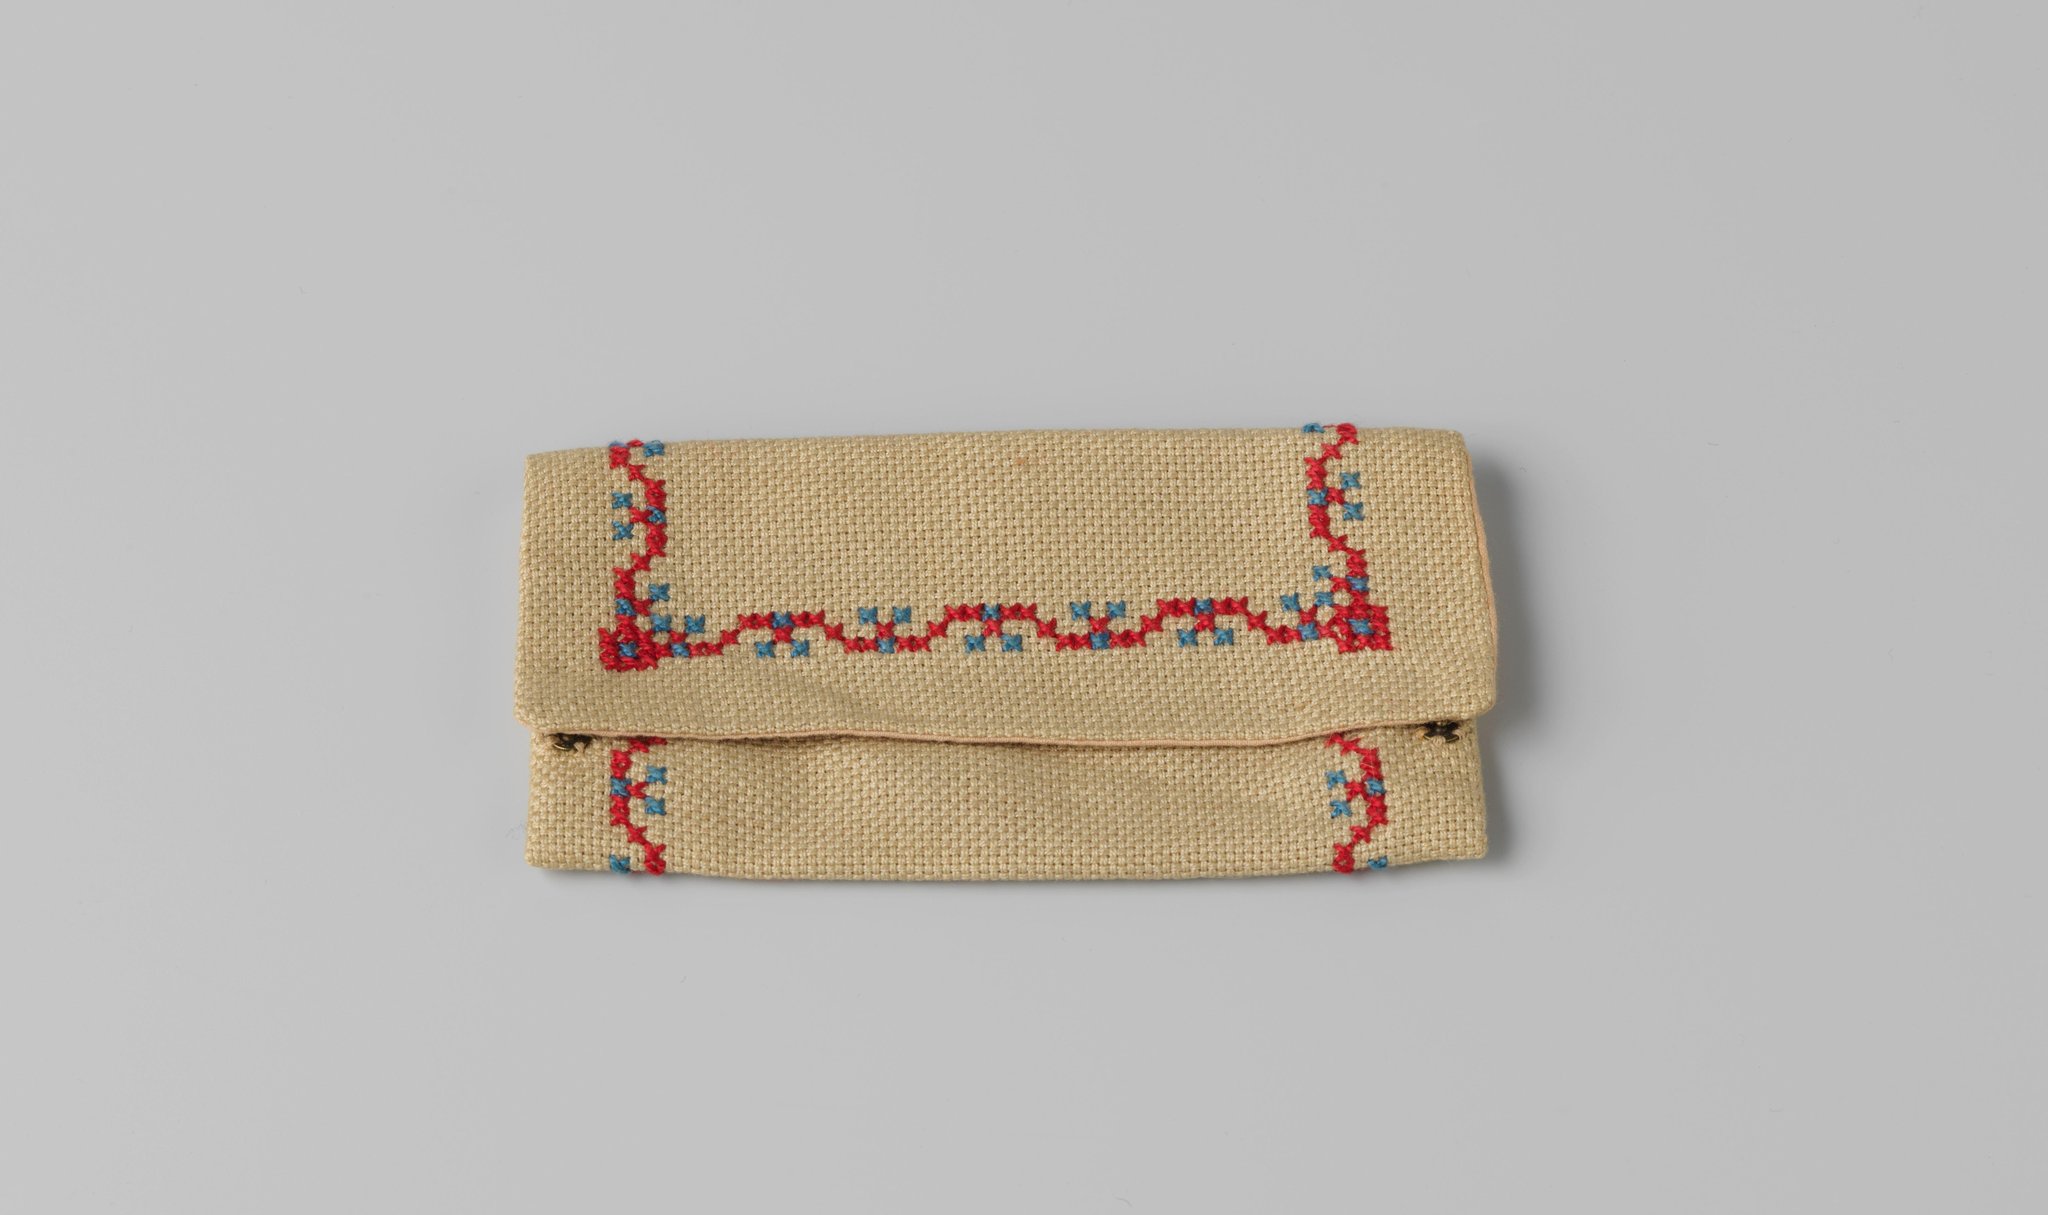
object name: sack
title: Reiszak horende bij de haarborstel van ivoor met monogram JVN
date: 1910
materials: metal, textile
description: Reiszak horende bij de haarborstel van ivoor. De reiszak is versierd met rode en blauwe geborduurde blokken.